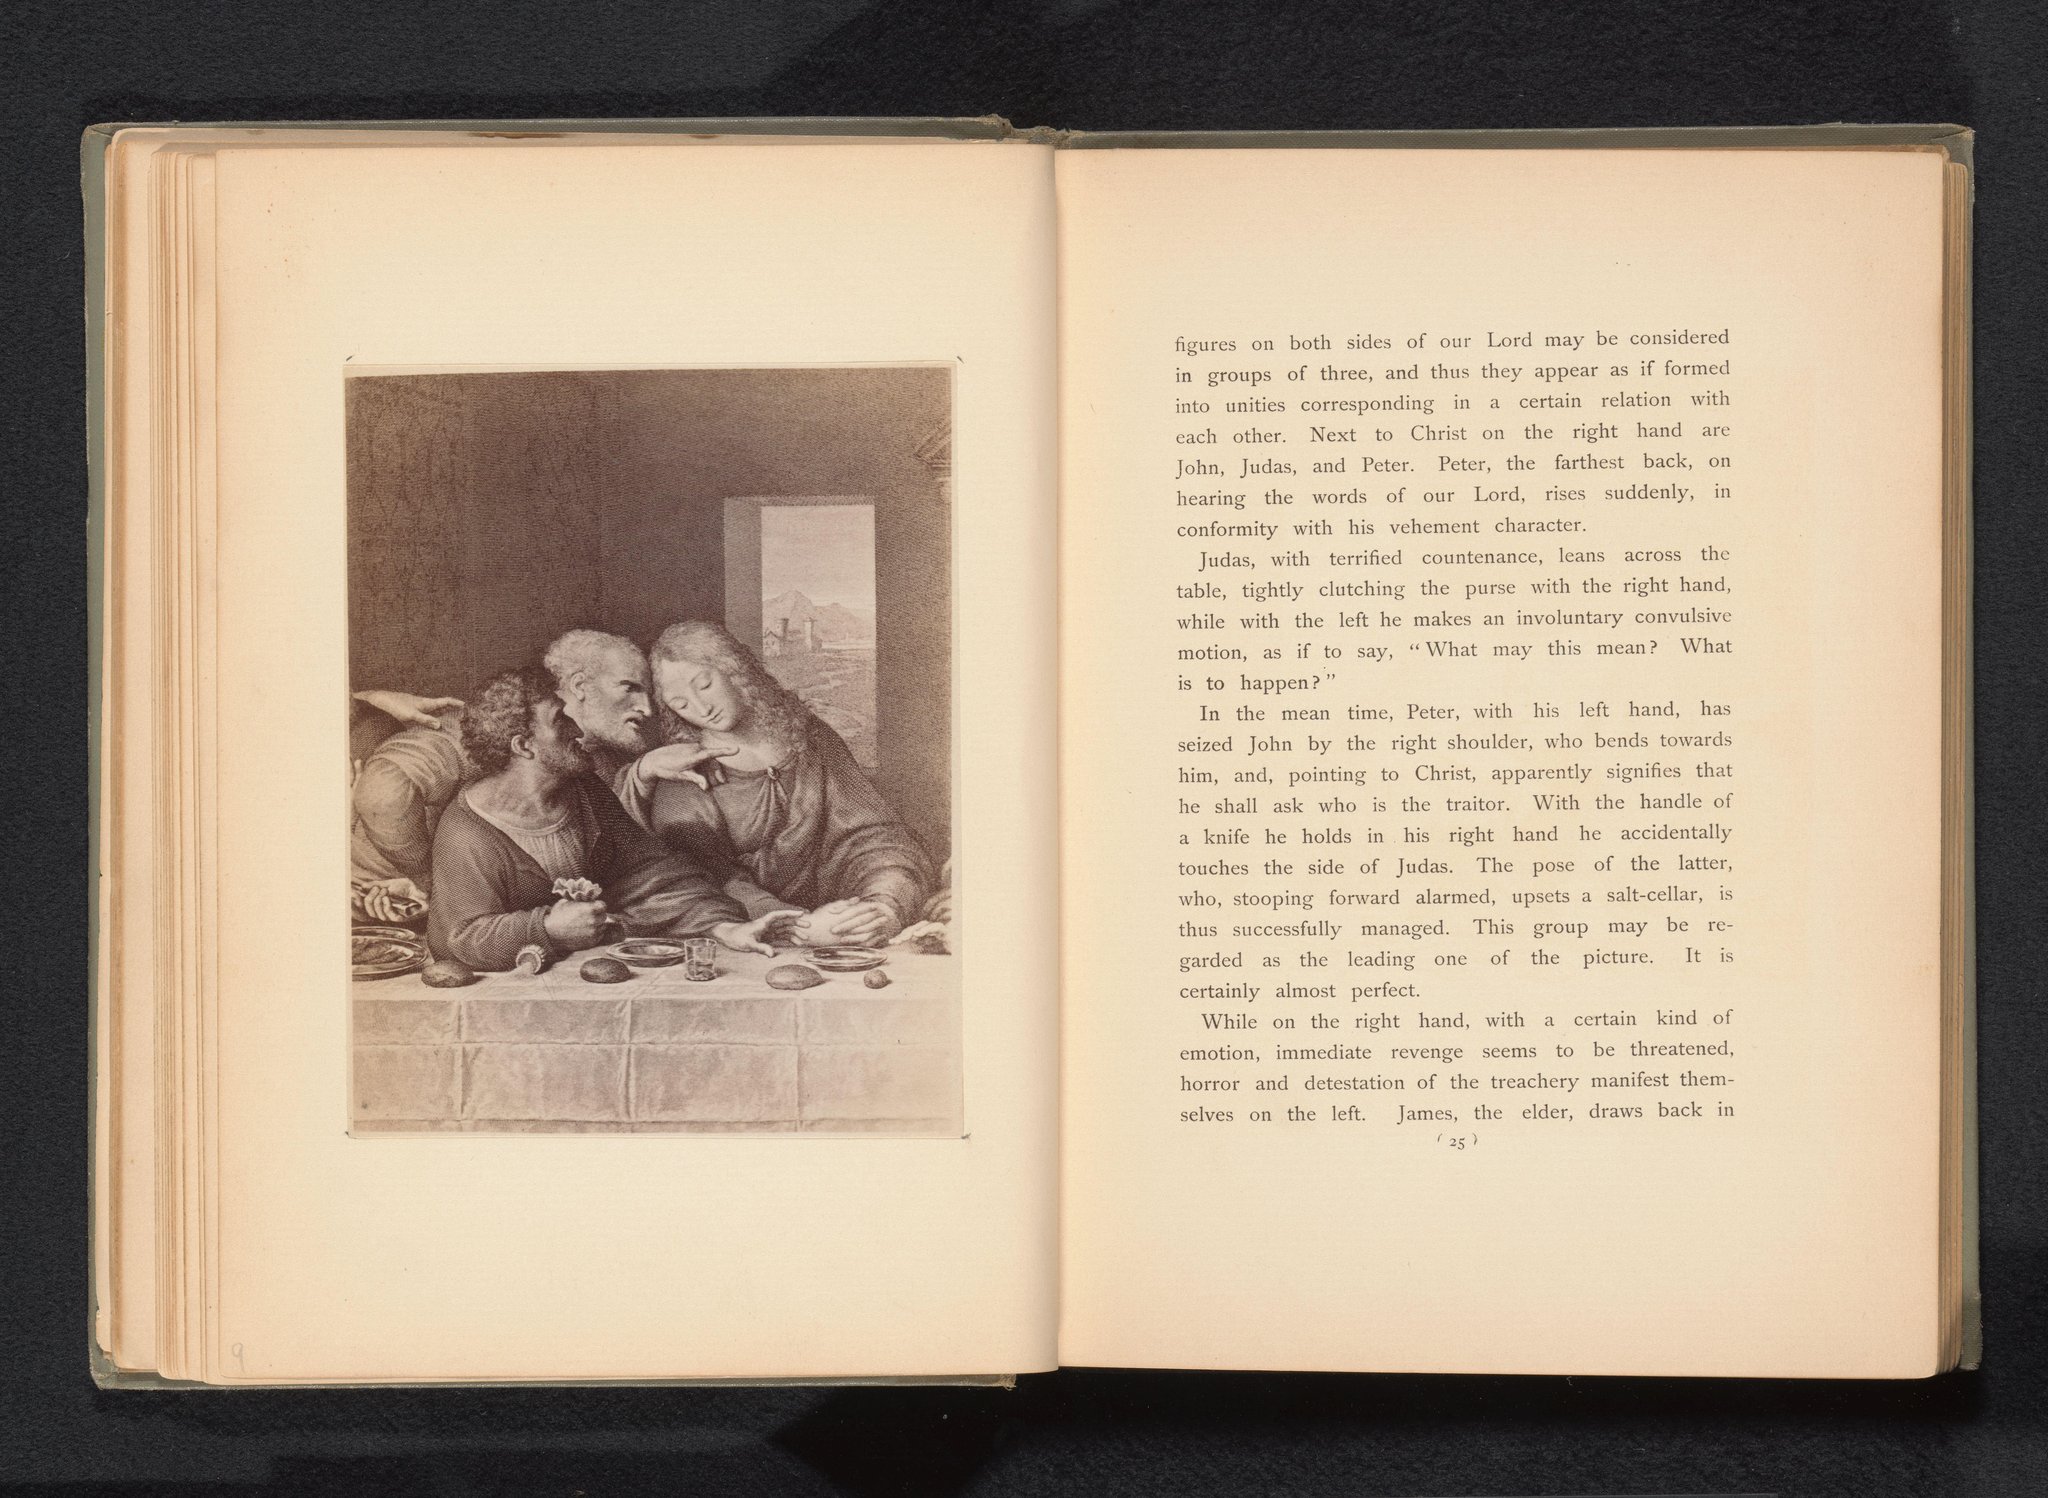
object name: photograph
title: Fotoreproductie van een prent naar een muurschildering, voorstellende het Laatste Avondmaal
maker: Anonymous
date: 1882-1887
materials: photographic support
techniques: albumen print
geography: s. maria delle grazie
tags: the episode of the last supper